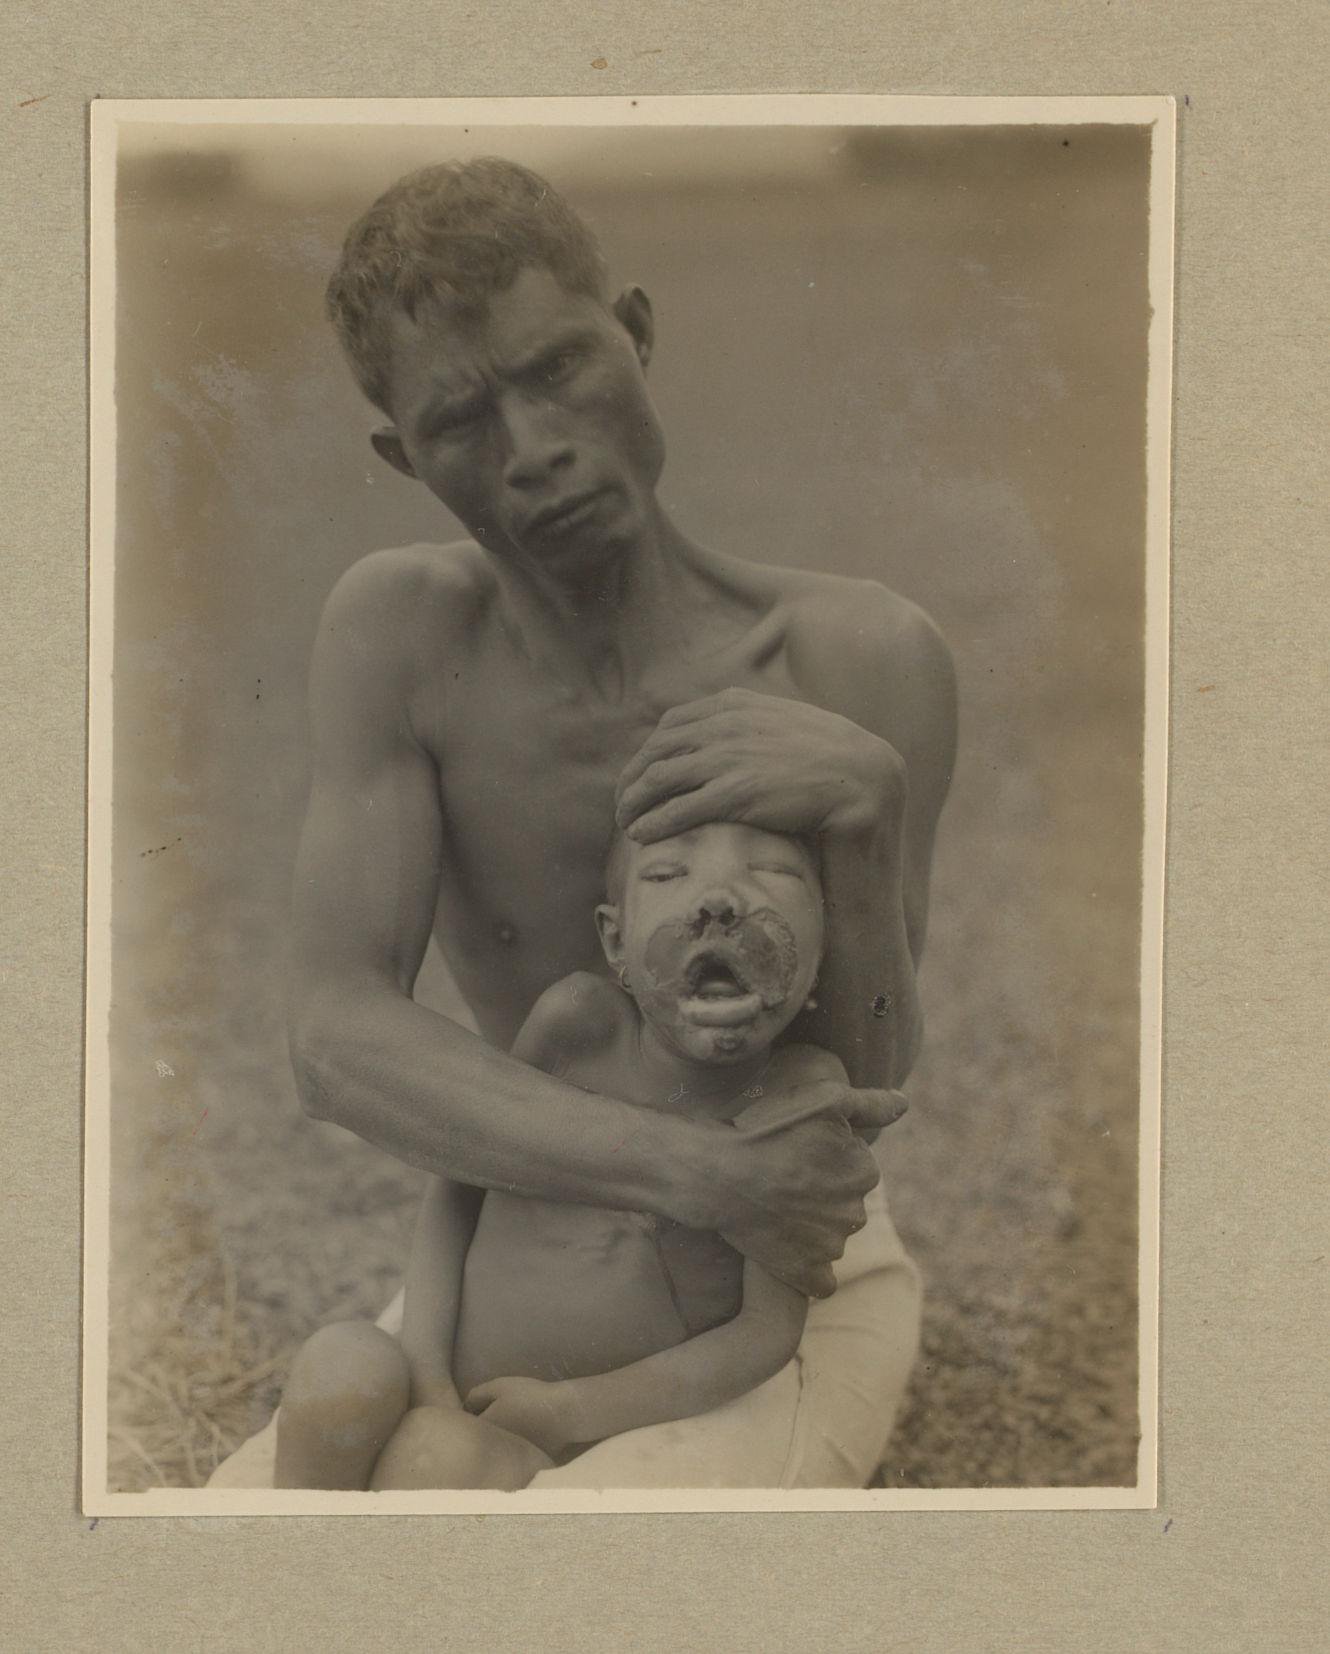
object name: photograph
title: Drie jarig meisje met NOMA (na mazelen), in de handen van de angstige vader.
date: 1929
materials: cardboard, photographic support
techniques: gelatin silver print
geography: kabanjahe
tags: colonial system, patient, sick person, sumatra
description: Medische foto van een driejarig meisje genaamd Emat Tarigan met de ziekte noma rond de mond. De vader houdt zijn dochter in de armen. Datum van foto: 29 september 1929. Foto geplakt op voorgedrukt kartonnen blad ingebonden in het fotoalbum over het Hospitaal Batak Instituut te Kabanjaheh op Sumatra in de jaren 1926-1929.